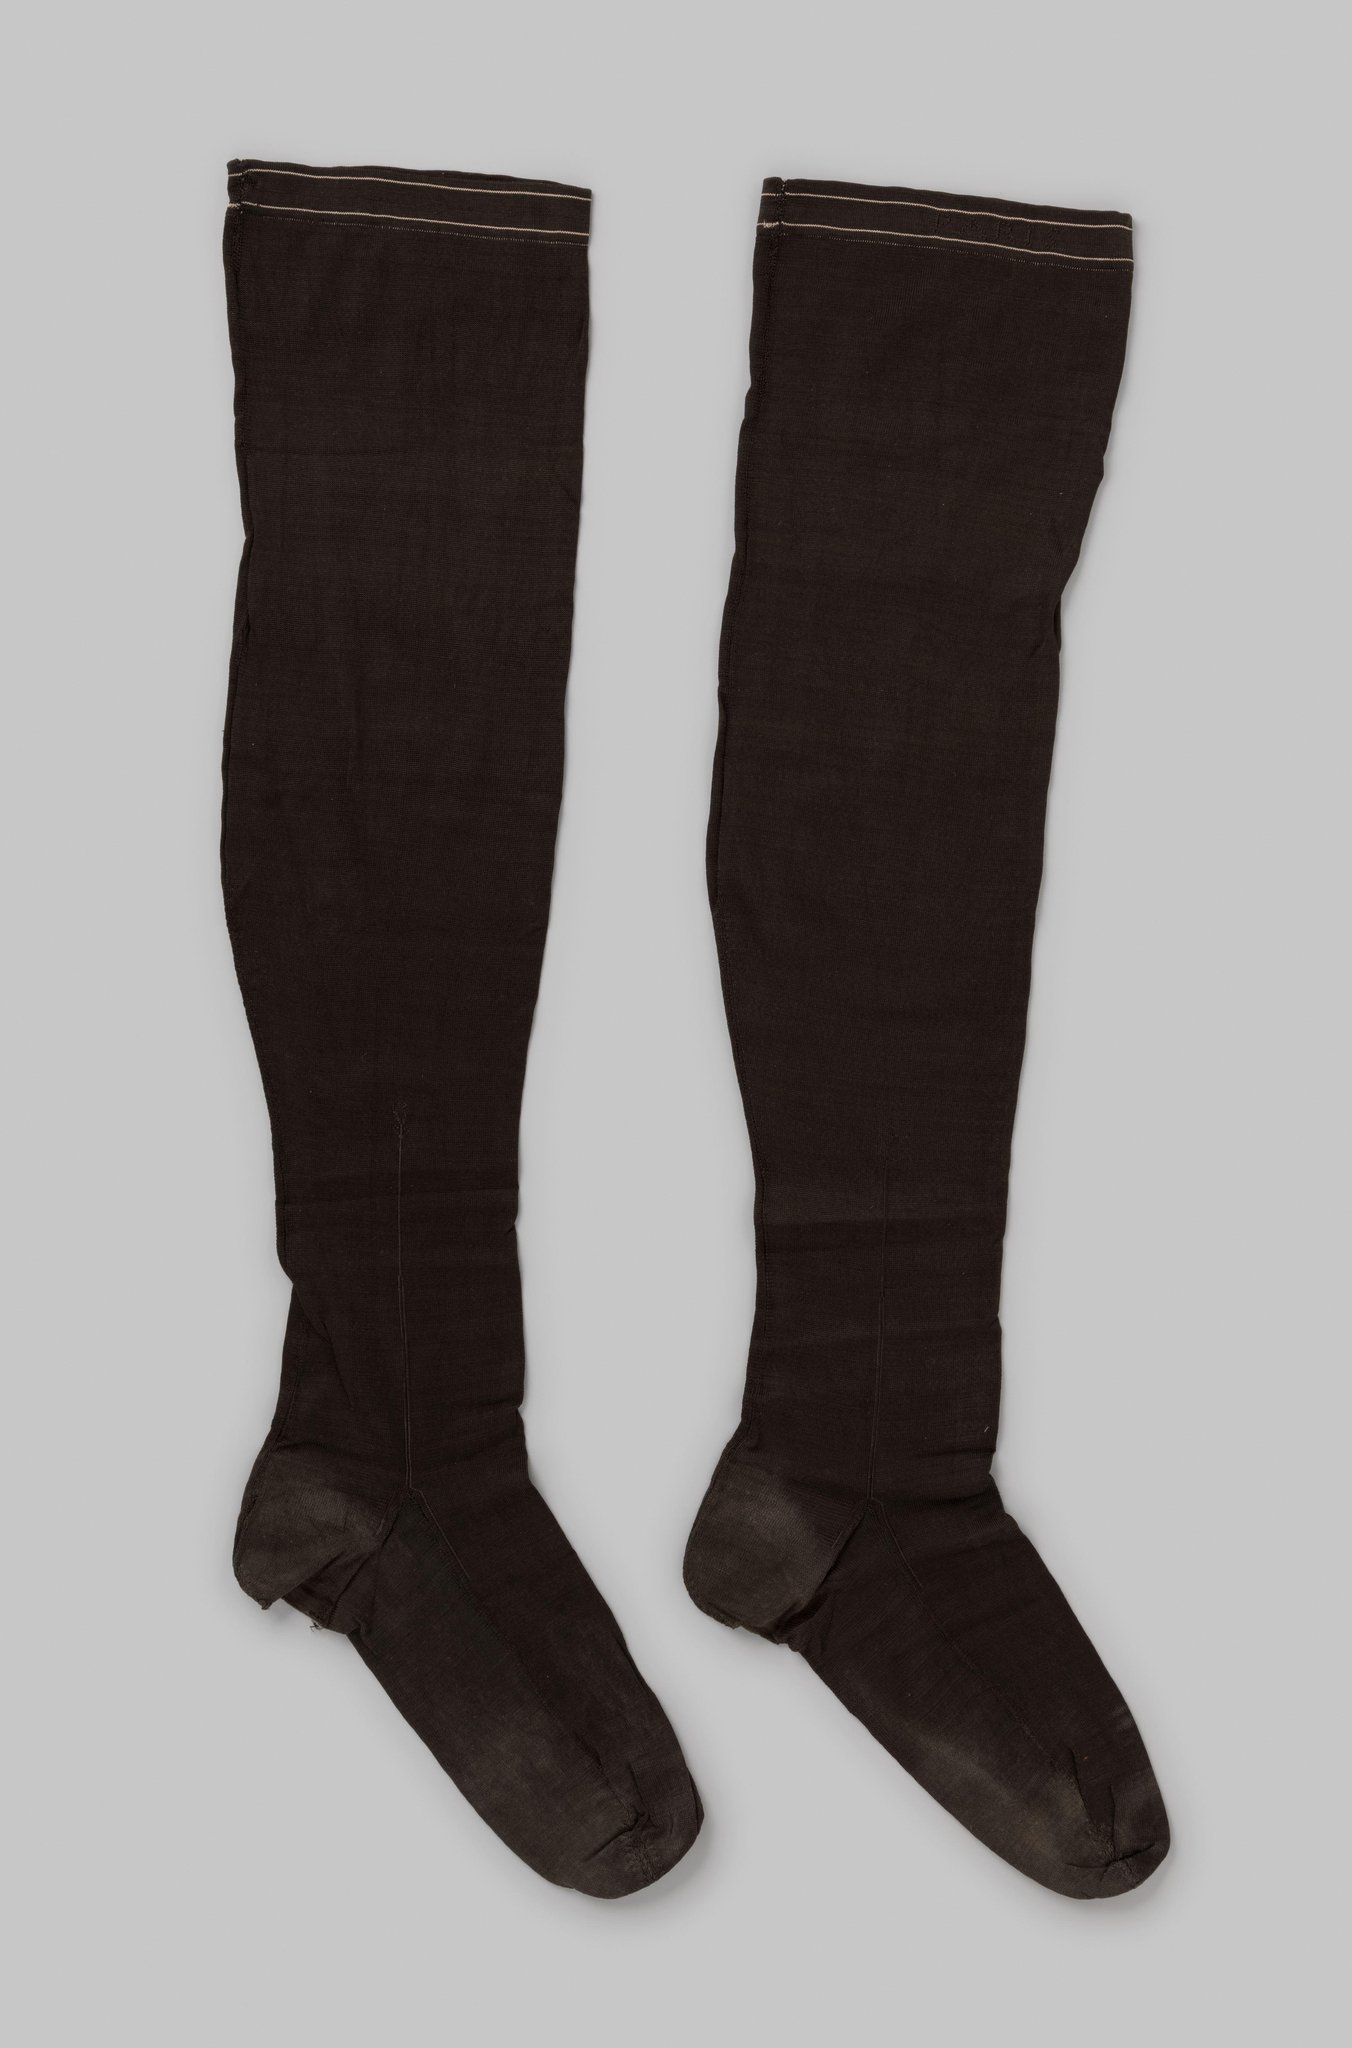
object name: clothing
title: Kous van effen glanzende donkerbruin of zwarte katoenentricot met bij de klink een geborduurde verticale lijn, uitlopend in een bloem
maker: Anonymous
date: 1700-1800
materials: cotton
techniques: embroidered, knitting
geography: paris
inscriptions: address: ‘PARIS’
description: Kous, deel van een paar, van glanzende zwarte katoenen tricot, met naad. Aan beide zijden hiel geborduurde verticale lijn uitlopend in een bloem. Aan bovenzijde twee smalle ecrukleurige horizontale banden. Gebreid in de boord: PARIJS.